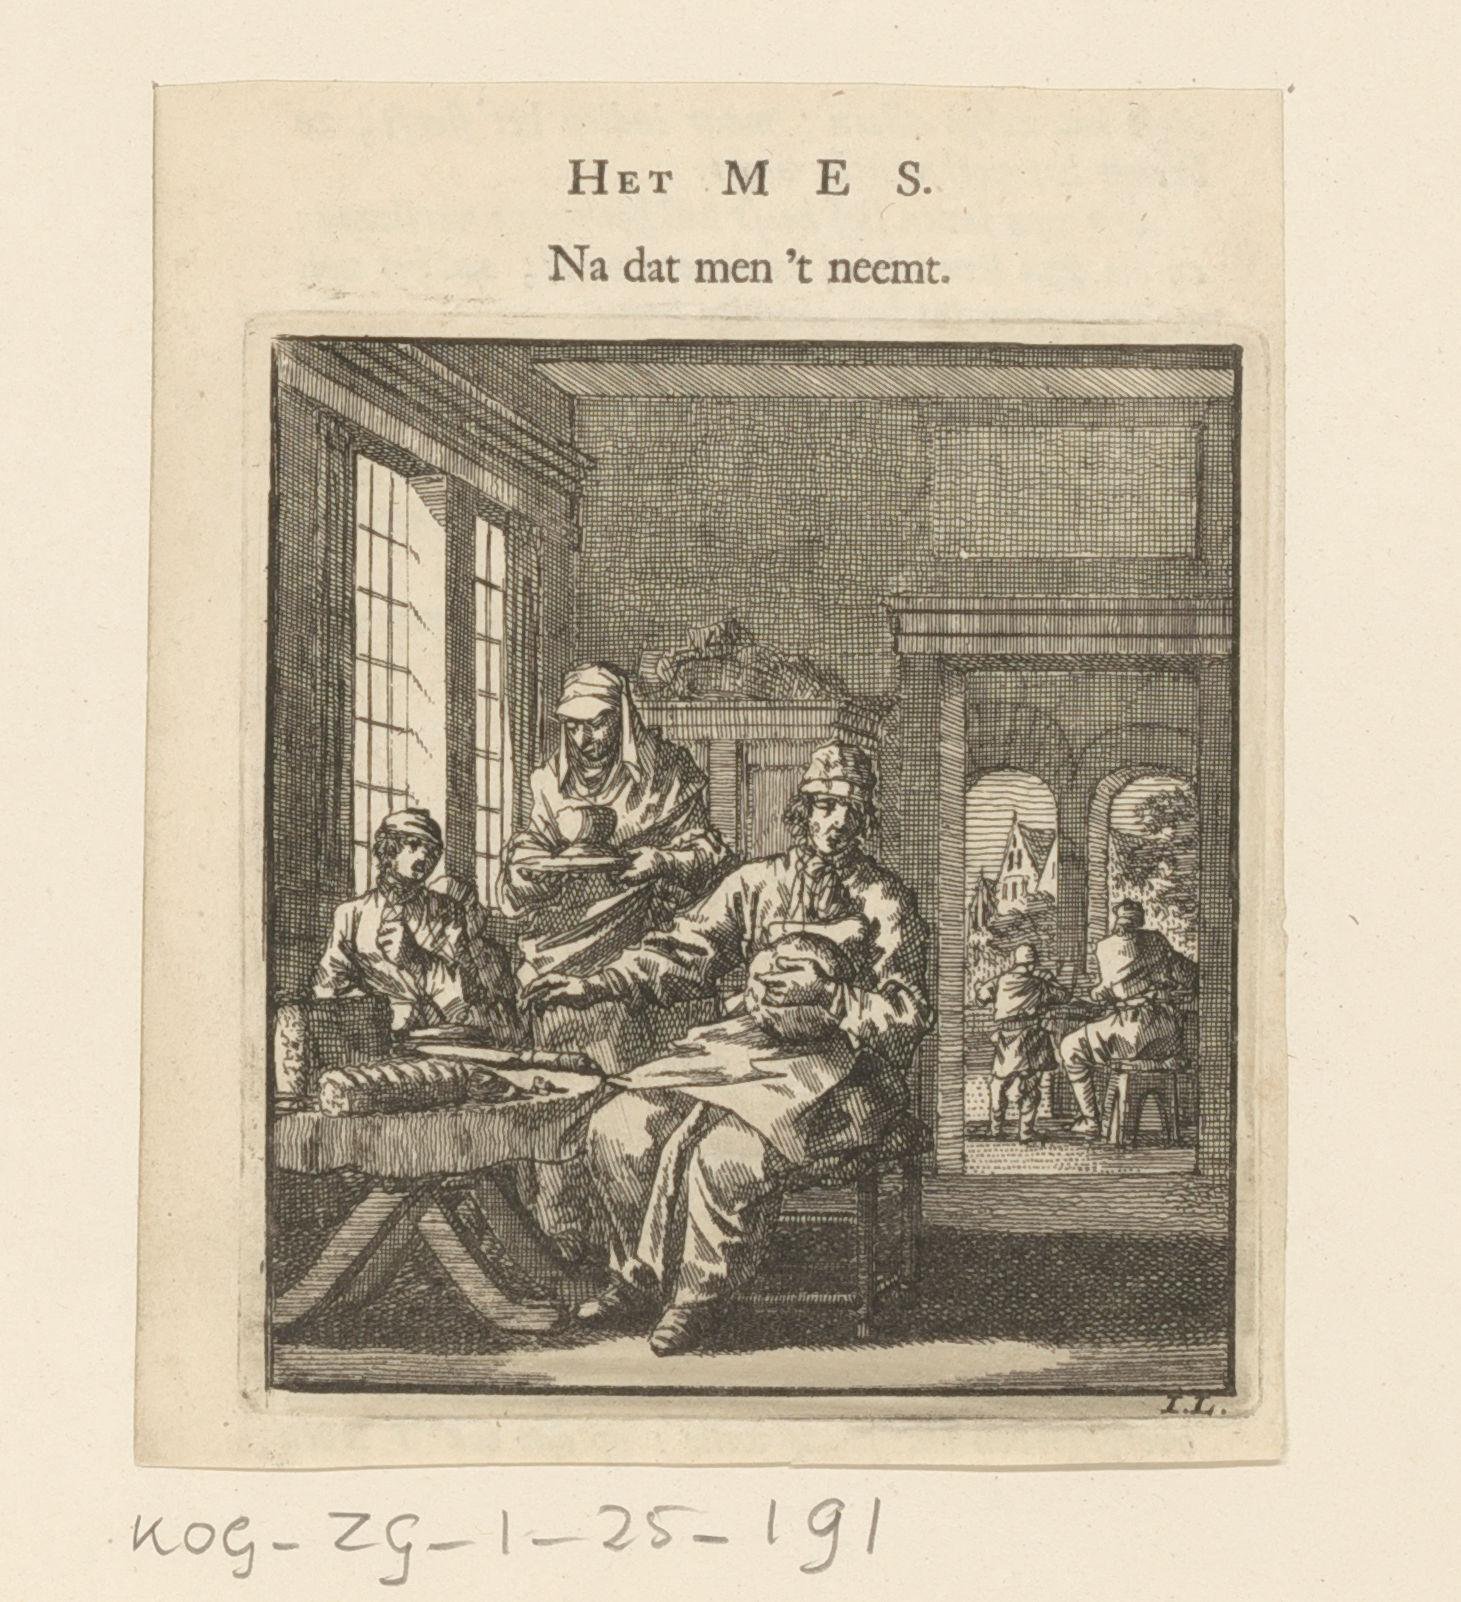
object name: book illustration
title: Enkele figuren bij een tafel met brood en een mes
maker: jan luyken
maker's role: draughtsman, print maker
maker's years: 1649-1712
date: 1711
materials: paper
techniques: etching, letterpress printing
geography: amsterdam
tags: bread, loaf, tools, aids, implements ~ crafts and industries: knife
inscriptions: collector's mark: Lugt 1641, stamp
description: Prent uit: Luyken, Jan. Het leerzaam huisraad, vertoond in vyftig konstige figuuren, met godlyke spreuken en stichtelyke verzen. Amsterdam: weduwe Pieter Arentsz. II en Cornelis van der Sys, 1711, p. 130.